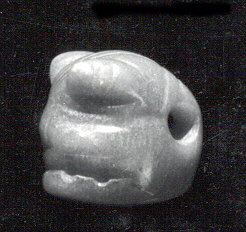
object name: bead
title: Bead with Head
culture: atlantic watershed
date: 301-800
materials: jade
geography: costa rica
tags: heads